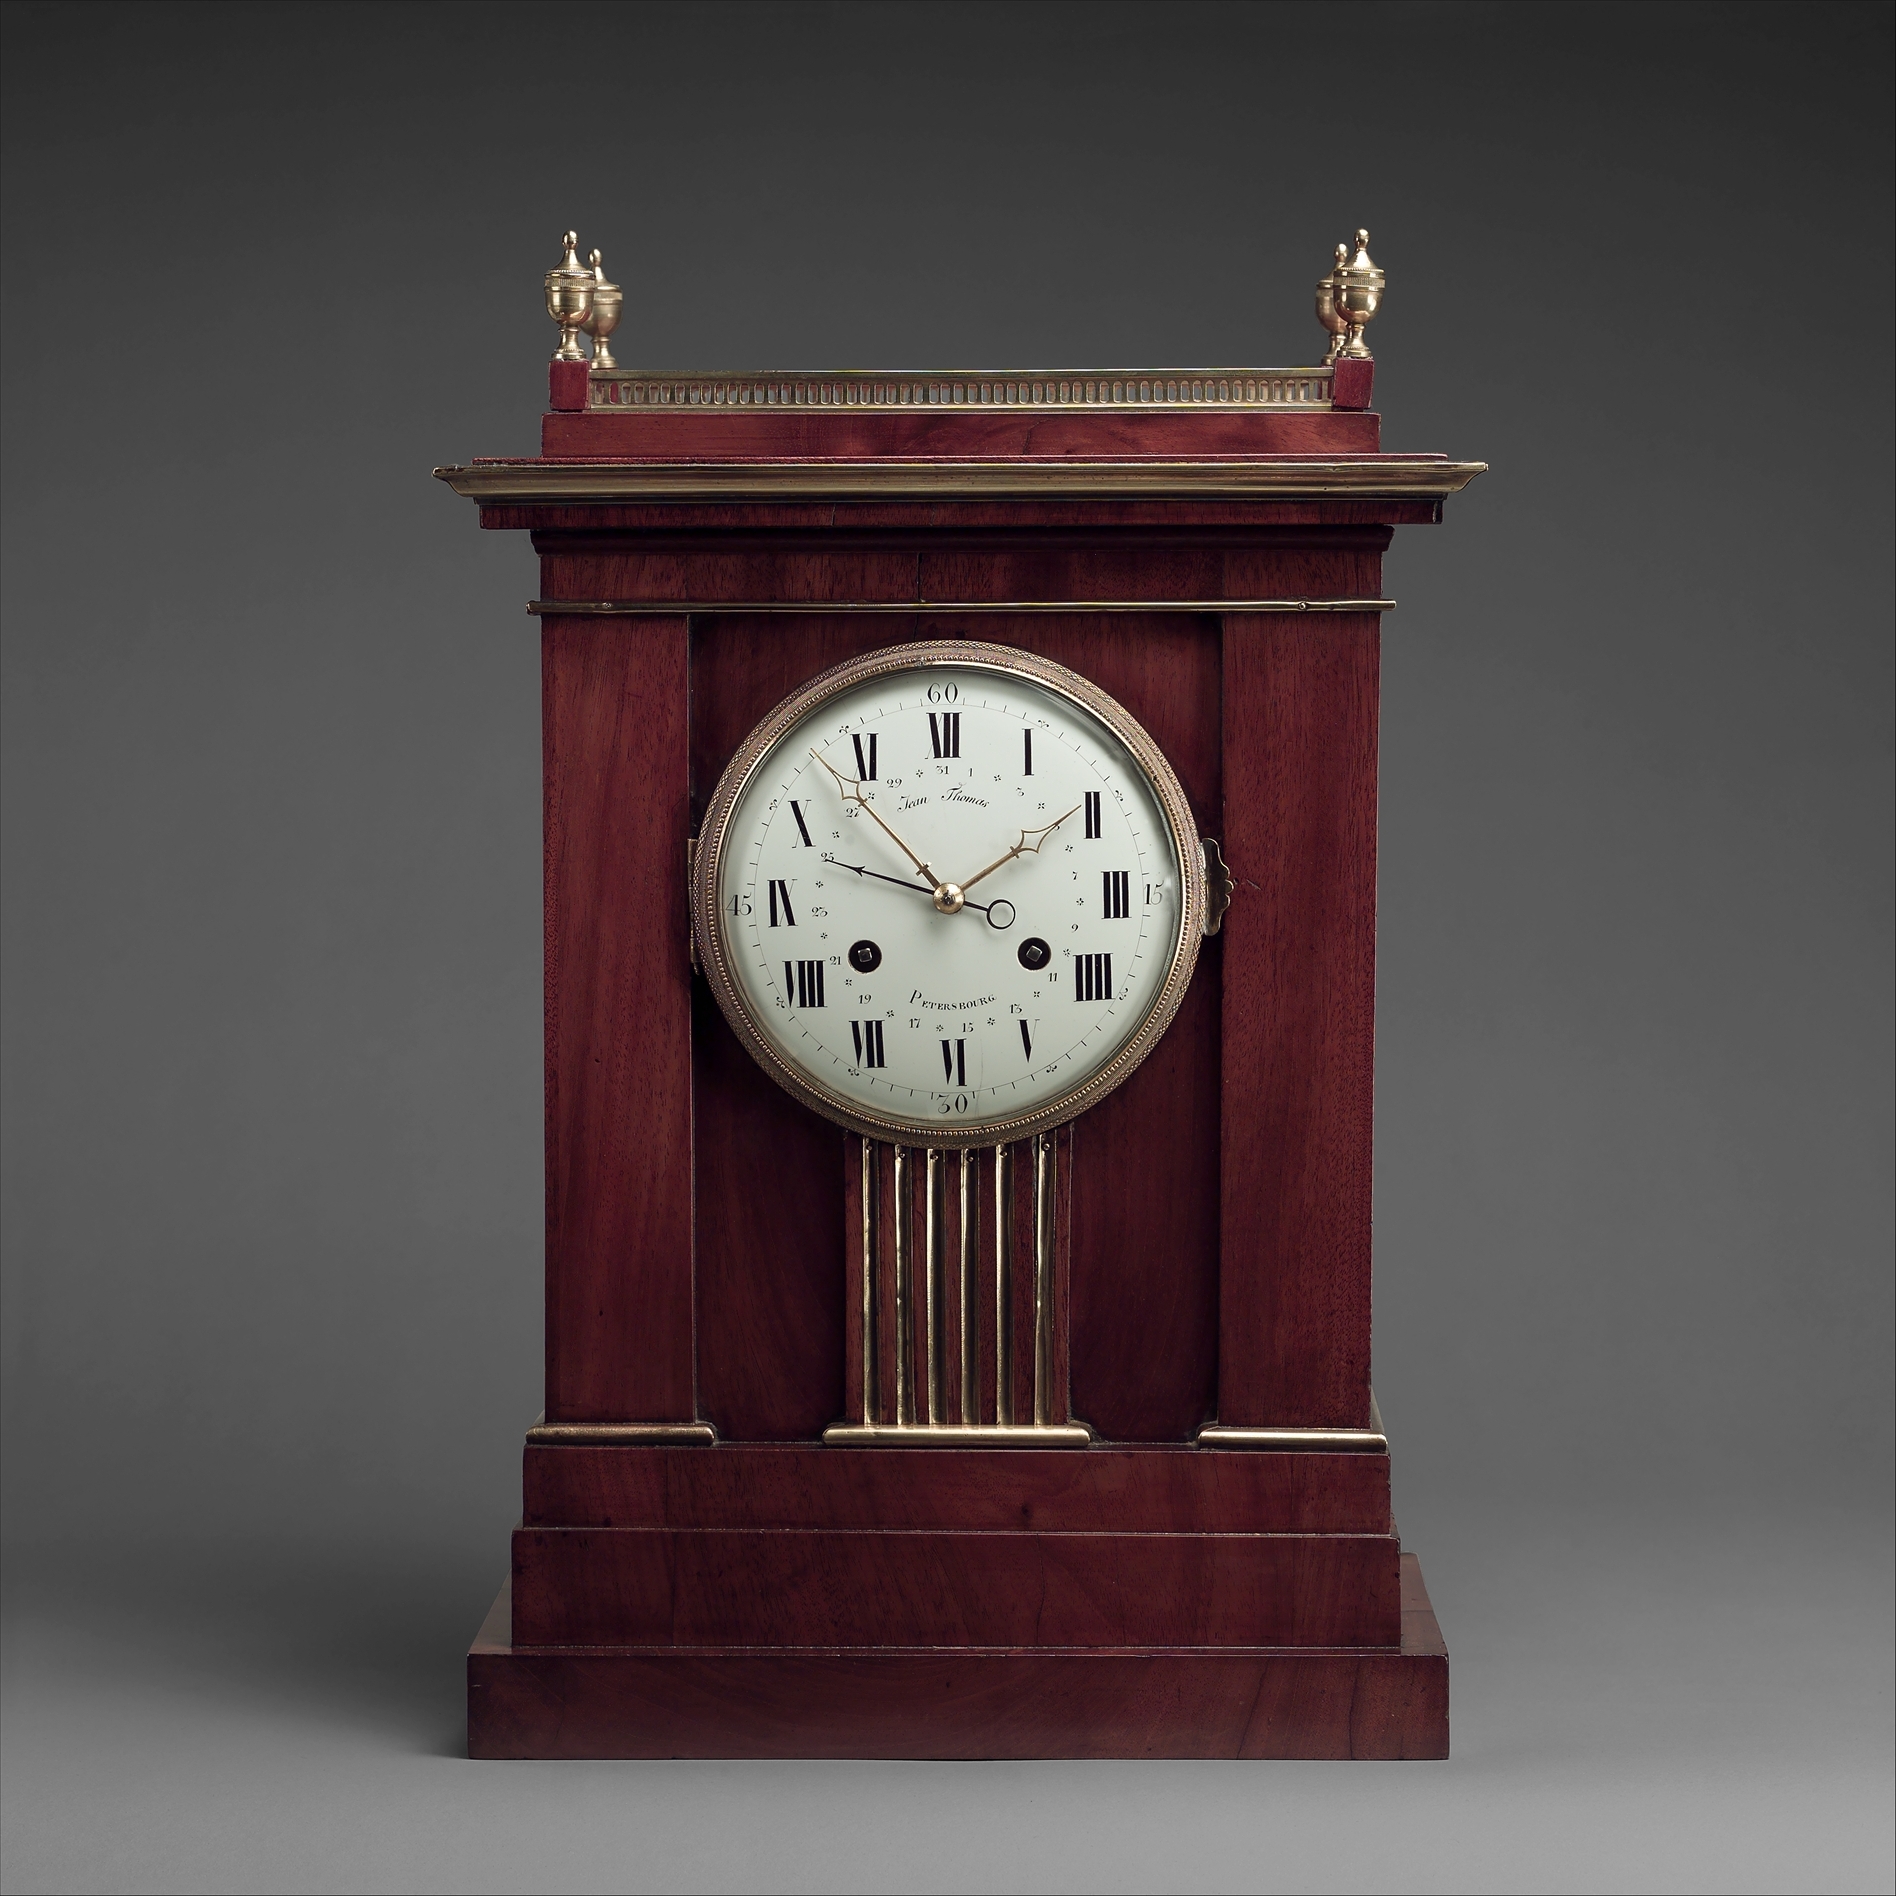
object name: clock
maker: david roentgen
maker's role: maker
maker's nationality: german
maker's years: 1743-1807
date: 1780-1790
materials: brass, enamel, gilt bronze, wood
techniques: veneering